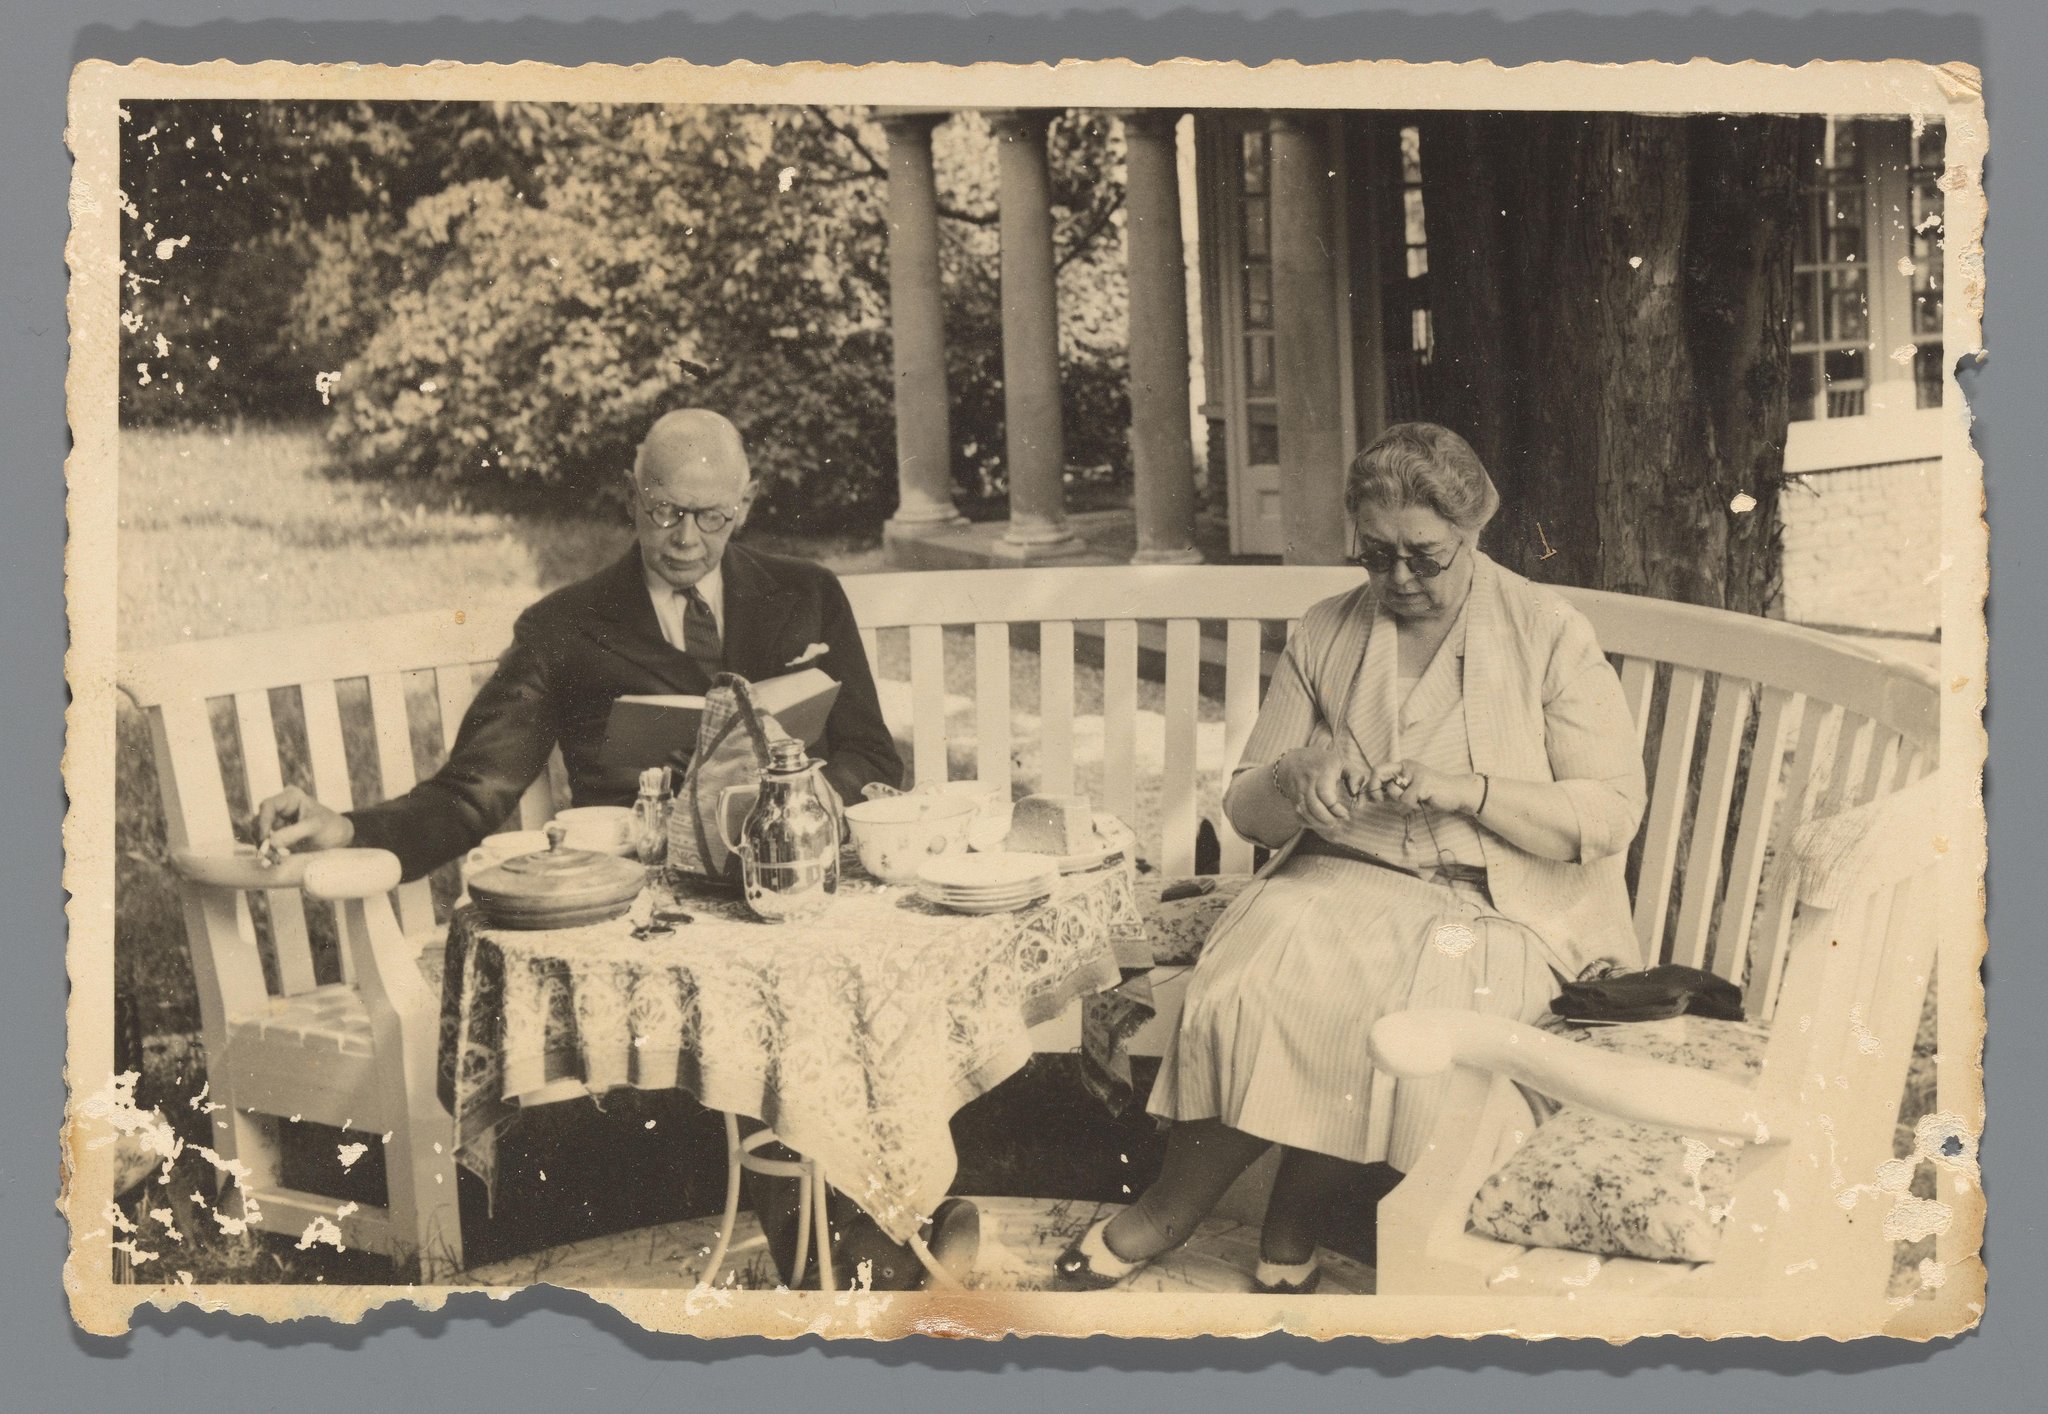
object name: photograph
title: Karel Frederik van den Berg lezend en een handwerkende vrouw op een bank buiten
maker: Anonymous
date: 1906-1941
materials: photographic support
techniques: photography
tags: batavia, karel frederik van den berg